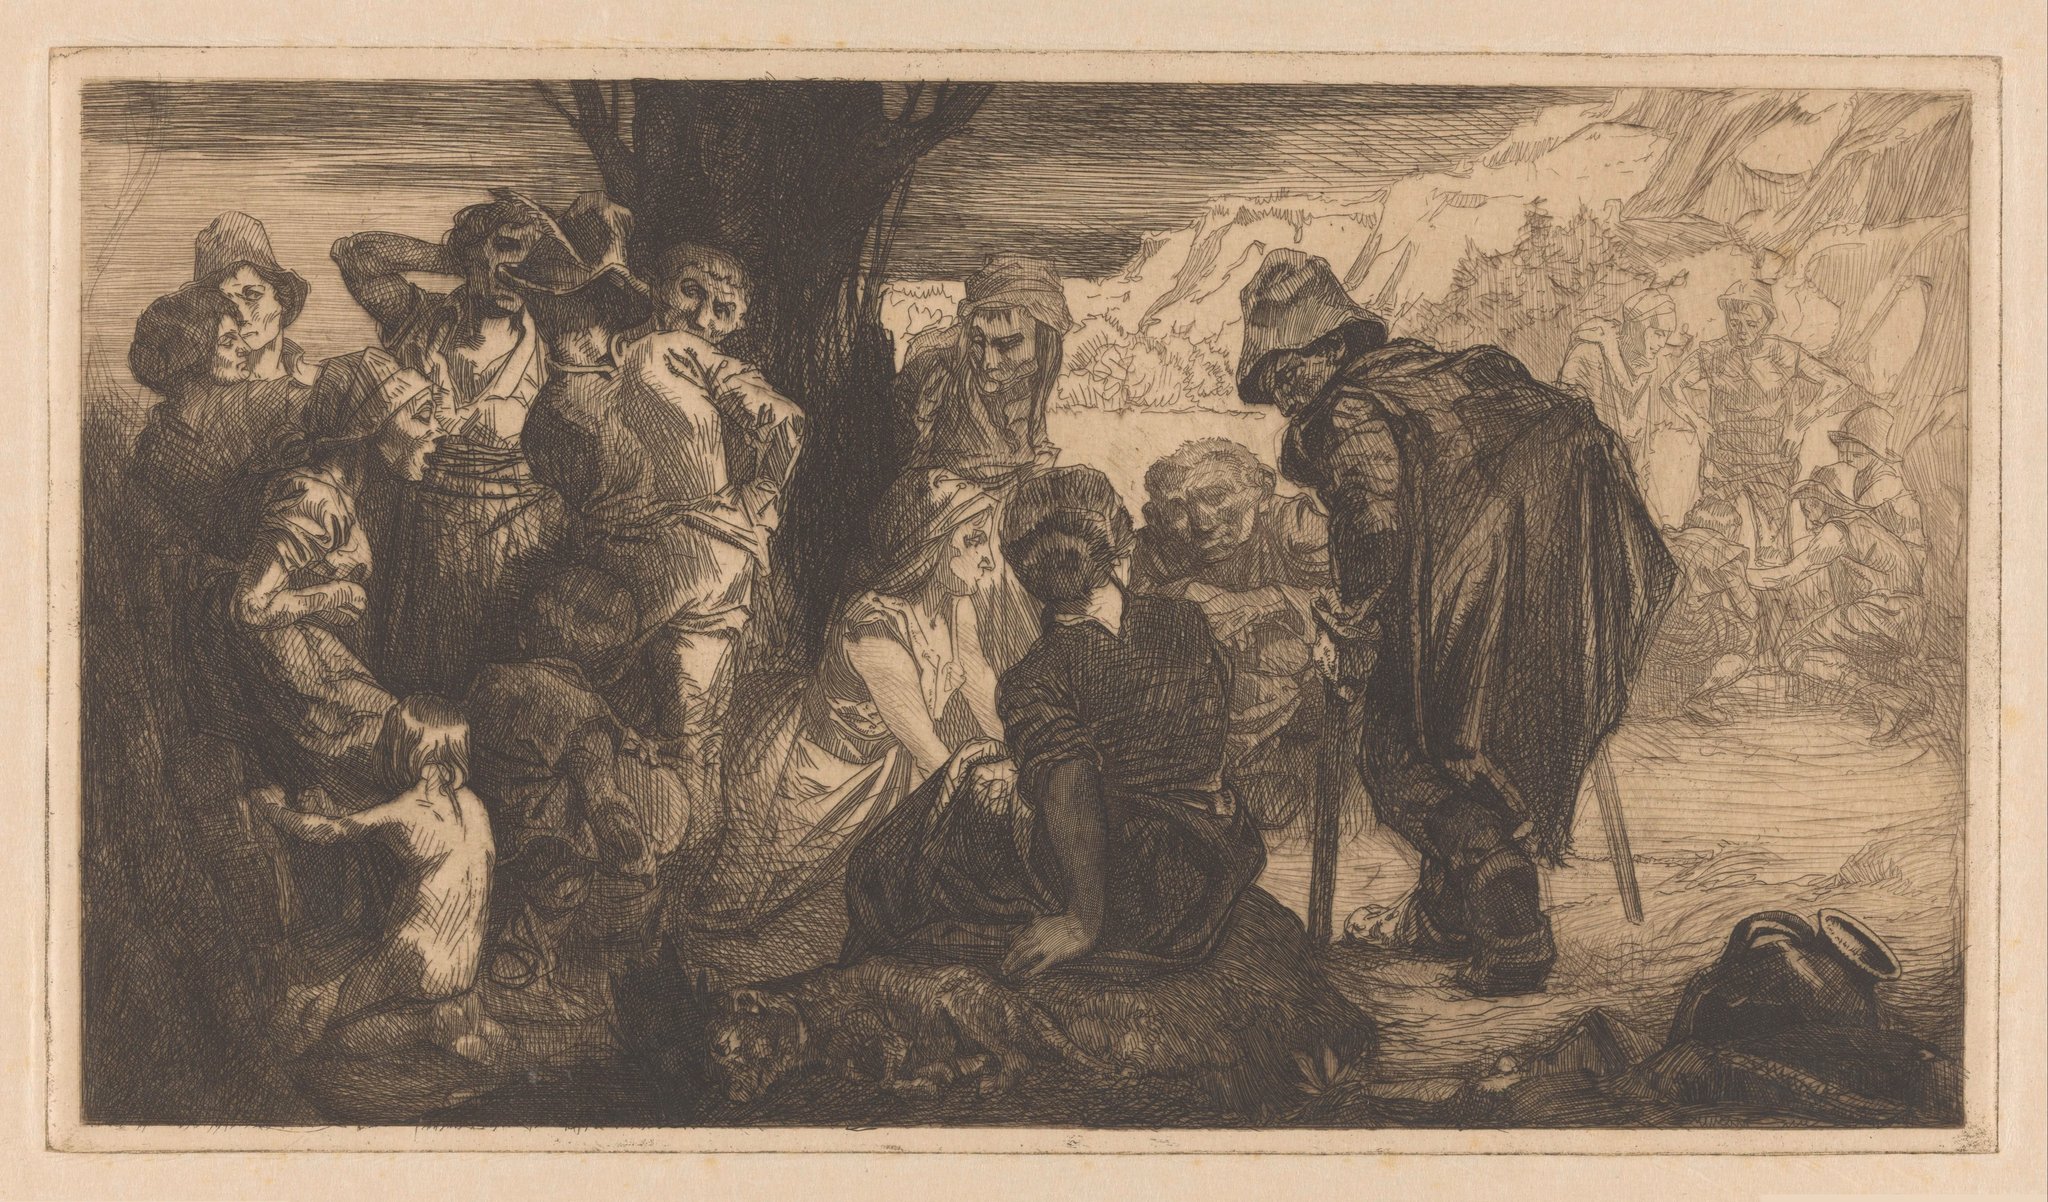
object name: print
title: Bedelaars en landloopers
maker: johannes josephus aarts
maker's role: draughtsman, print maker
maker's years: 1871-1934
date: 1881-1934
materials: paper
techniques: engraving, etching, roulette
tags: crutches, wandering communities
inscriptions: collector's mark: Lugt 2228, collector's mark: Lugt 2760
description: Een groep mannen, vrouwen en kinderen, waarschijnlijk Roma, houdt zich op bij een boom. Rechts op de voorgrond loopt een man met twee krukken. Achter de groep een open landschap, dat begrensd wordt door heuvels.